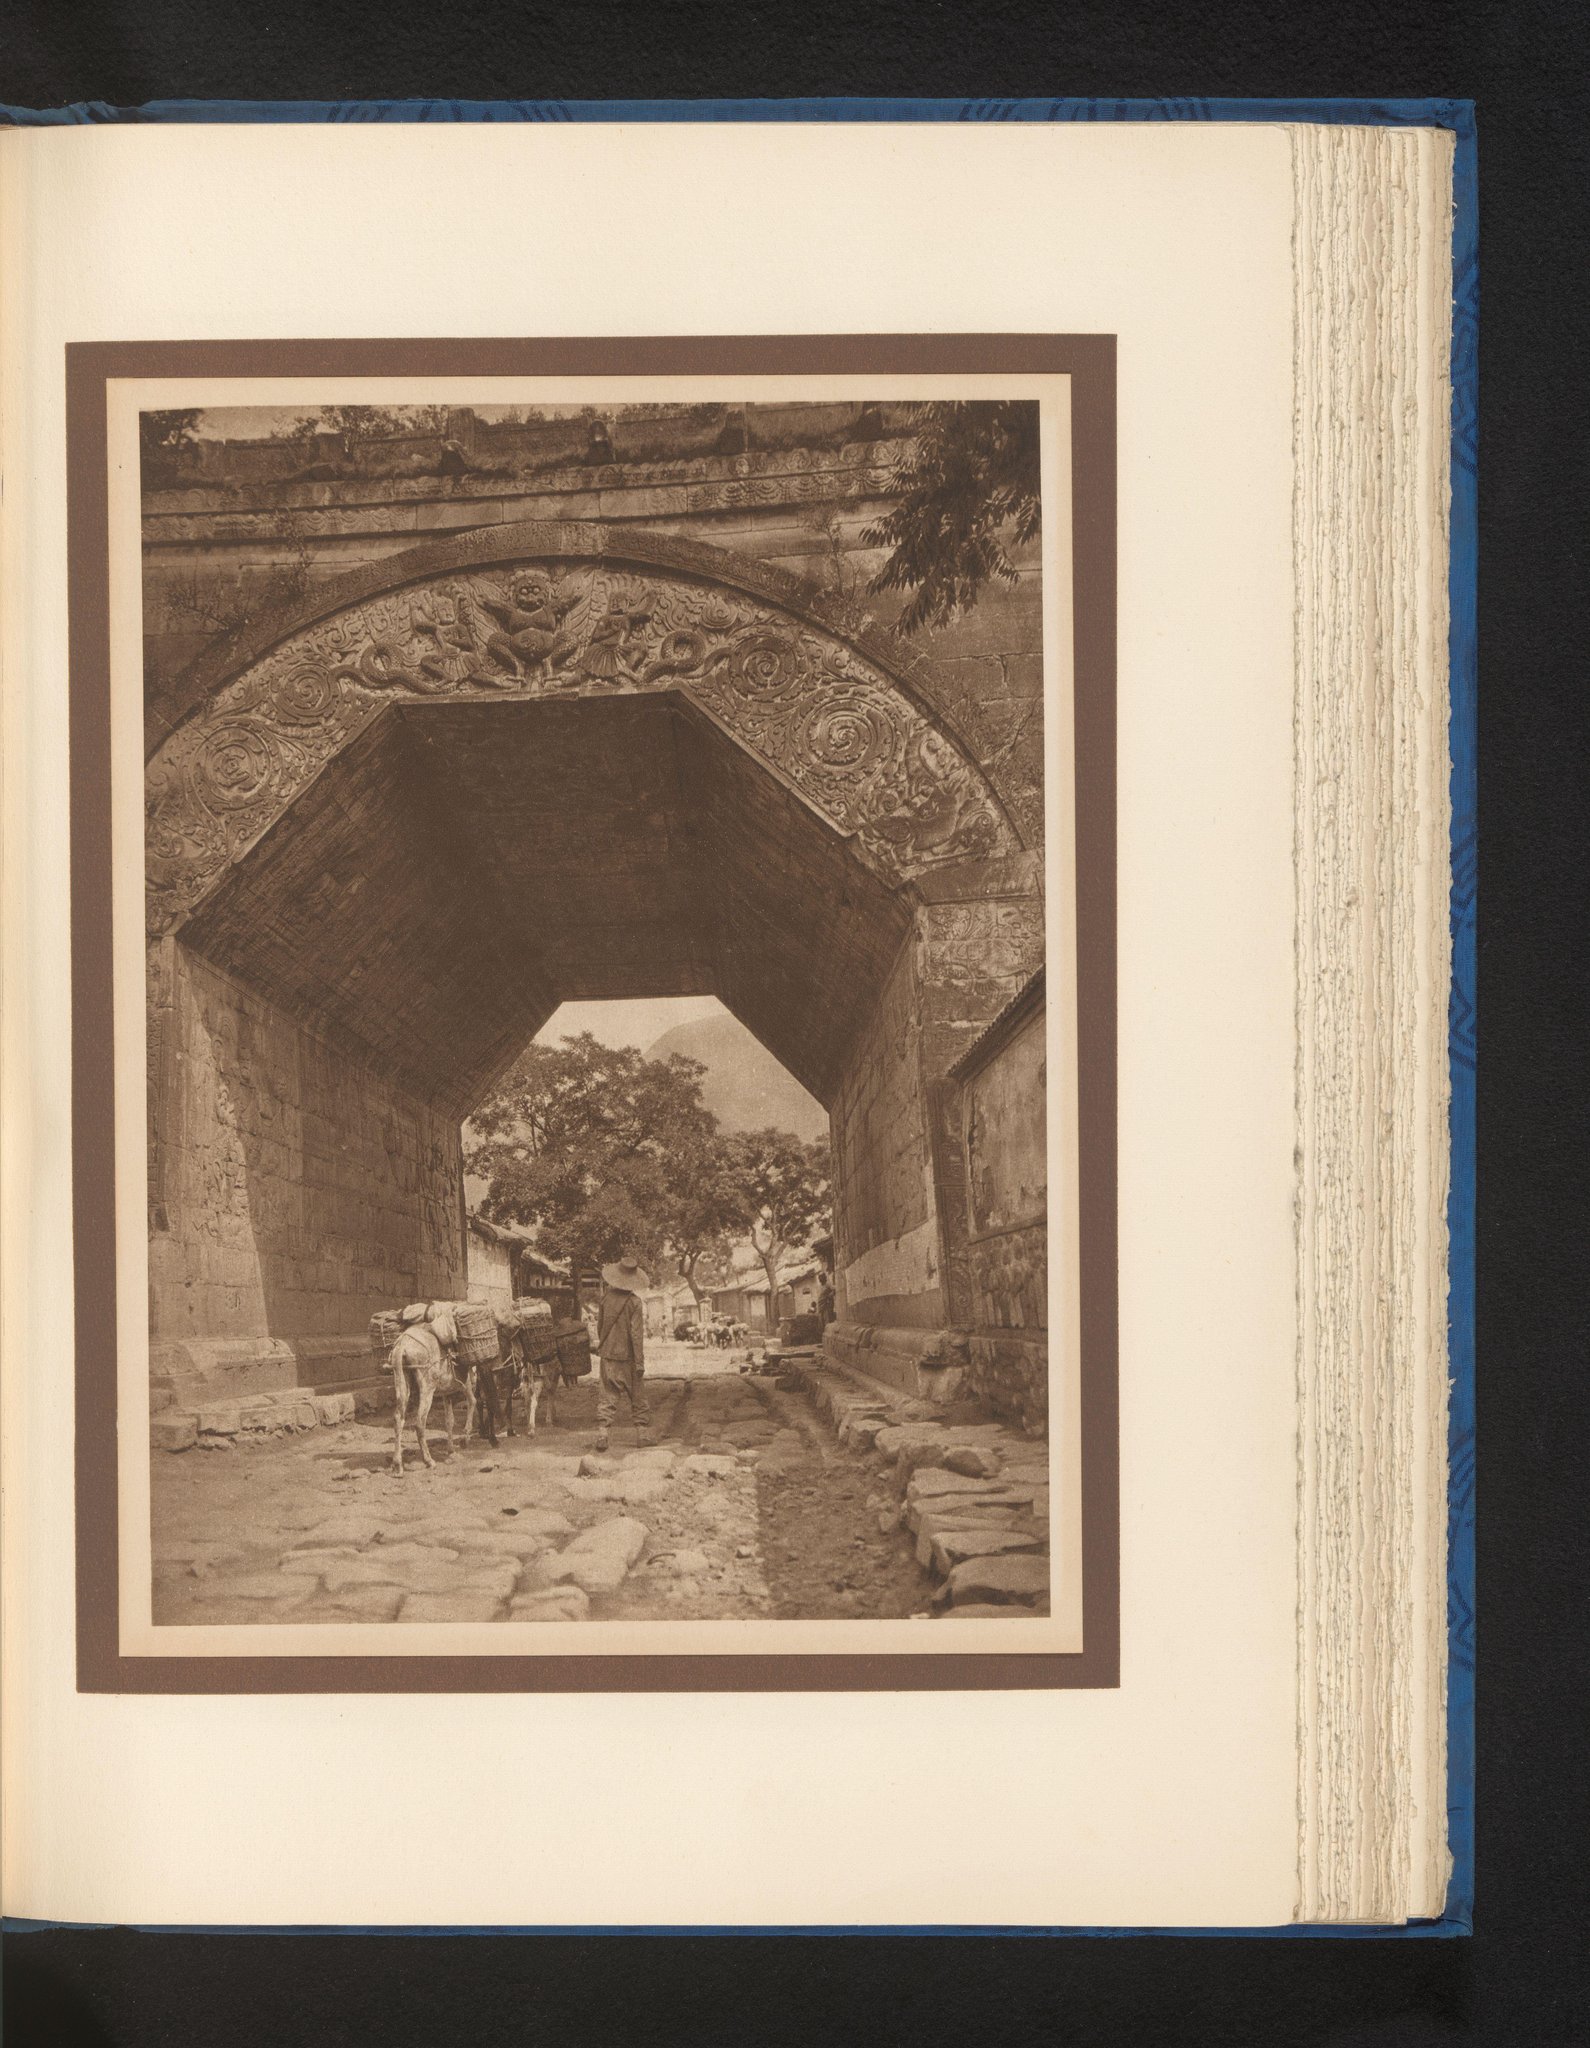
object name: page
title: Poort bij Juyong Guan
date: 1915-1920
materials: paper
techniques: rotogravure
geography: beijing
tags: gate, entrance